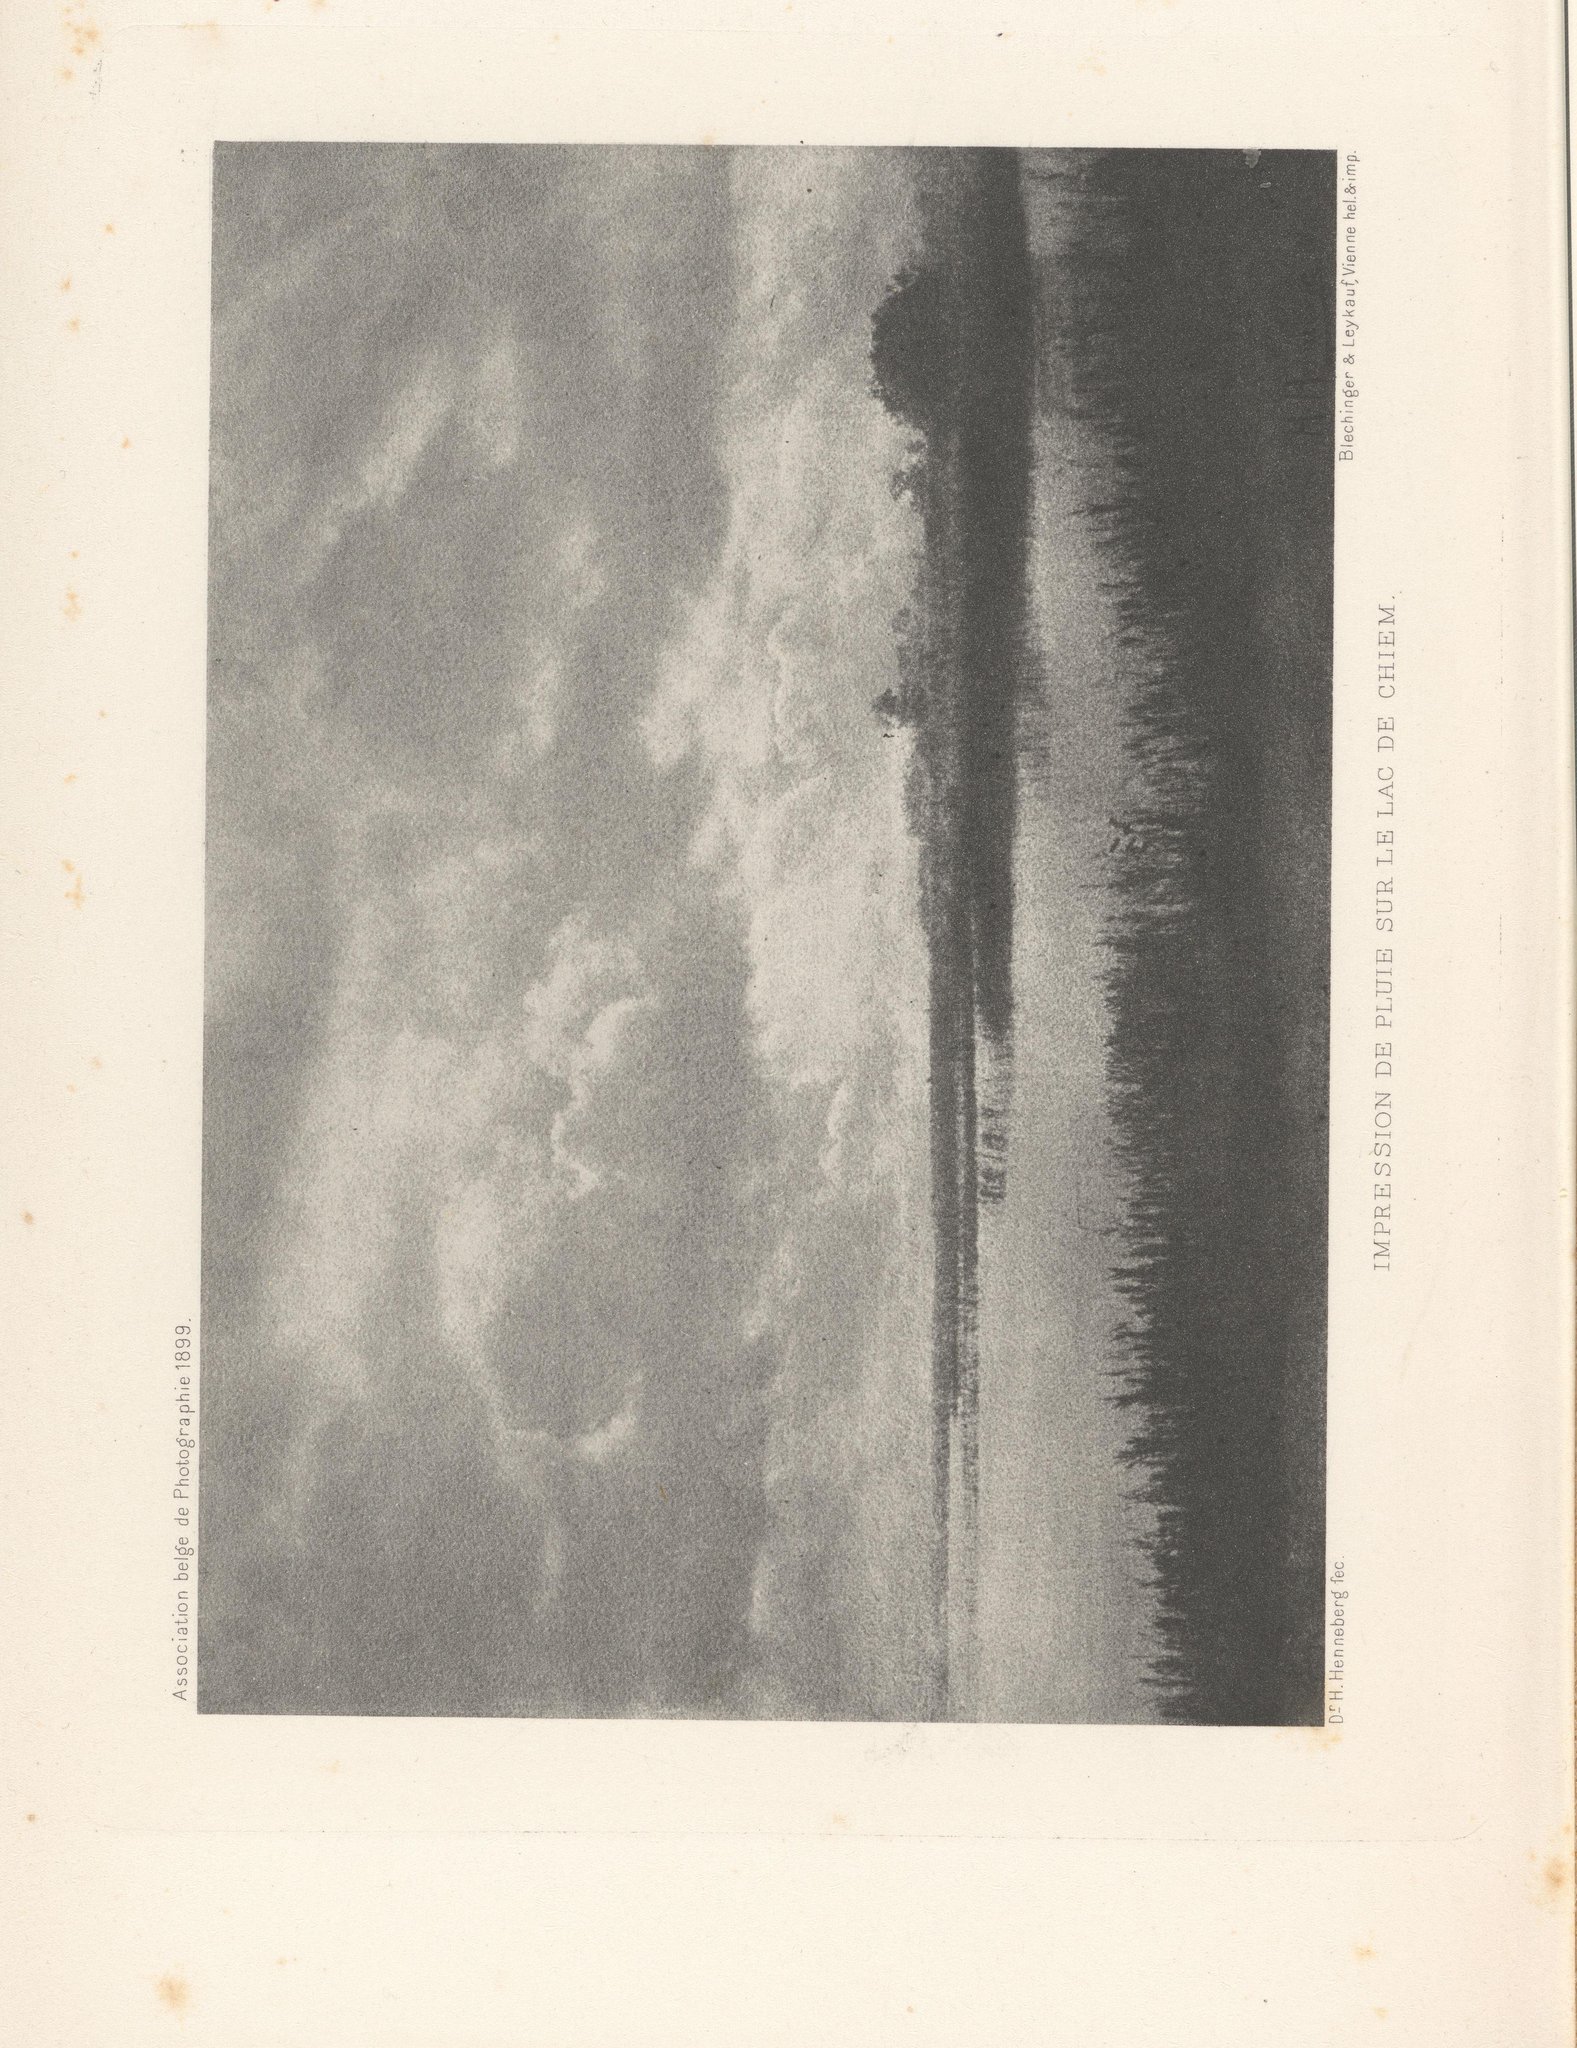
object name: photomechanical print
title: Gezicht op de Chiemsee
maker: hugo henneberg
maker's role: fotograaf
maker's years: 1863-1918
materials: paper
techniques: photoaquatint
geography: vienna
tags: lake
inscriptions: inscription: ‘Association belge de Photographie 1889.’